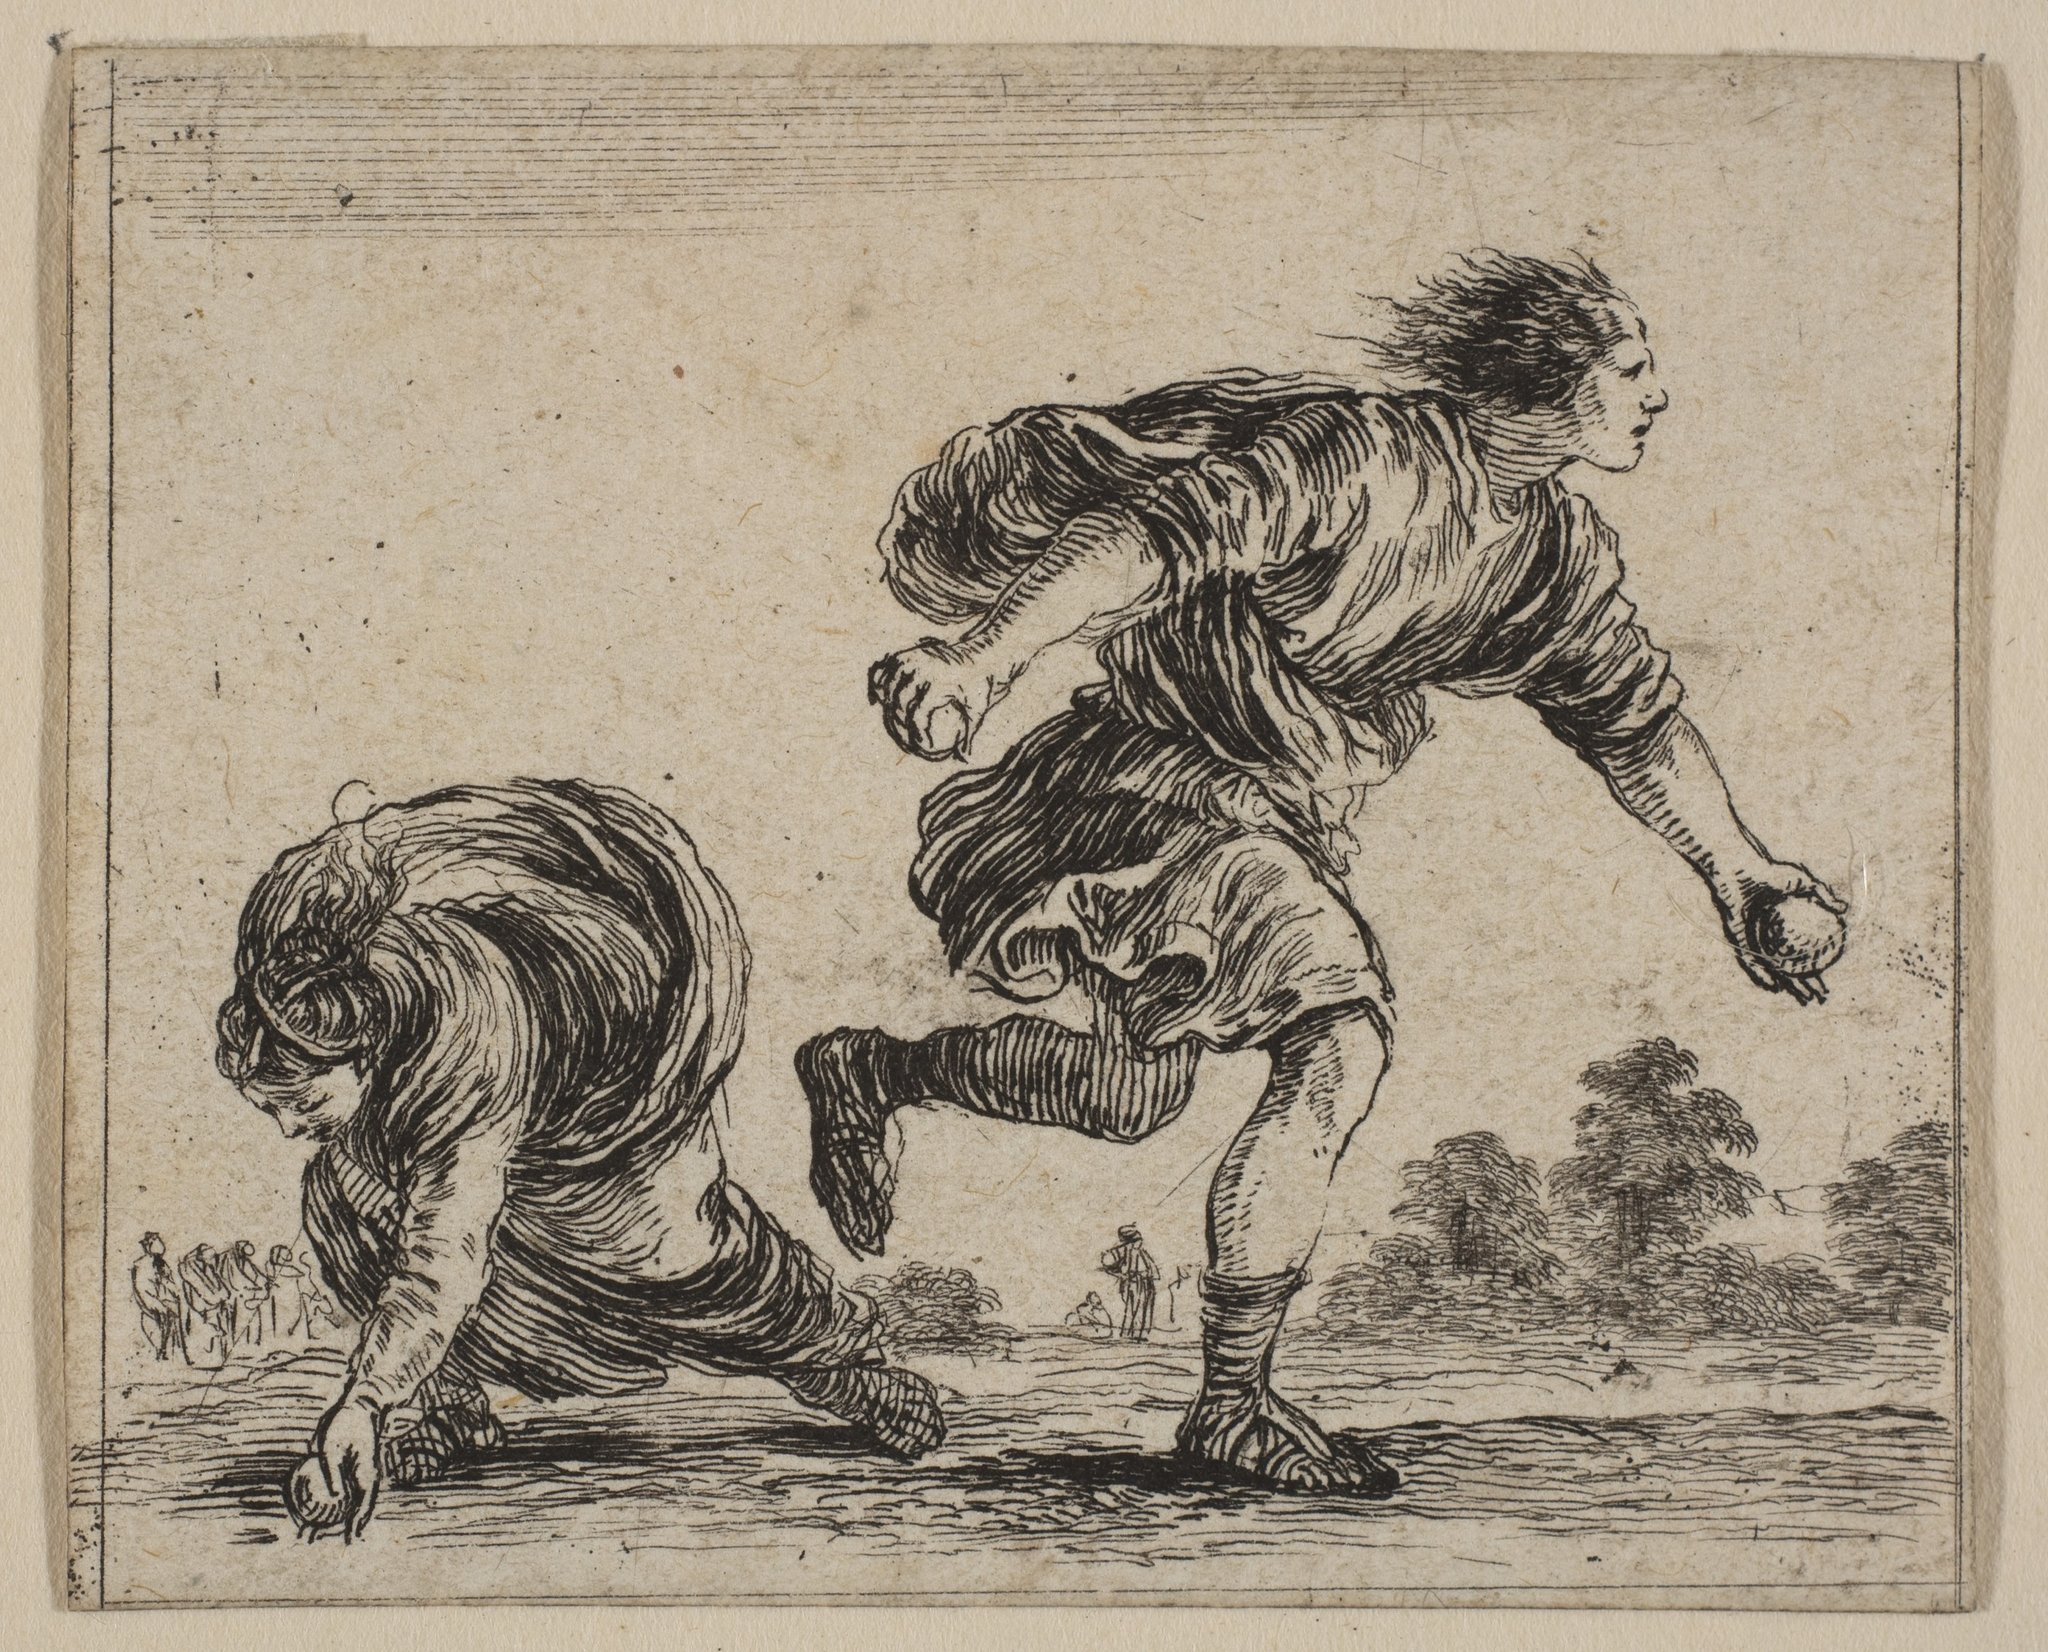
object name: print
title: Hippomenes and Atalanta, from 'Game of Mythology' (Jeu de la Mythologie)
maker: stefano della bella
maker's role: artist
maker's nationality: italian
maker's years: 1610-1664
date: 1644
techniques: etching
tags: men,women